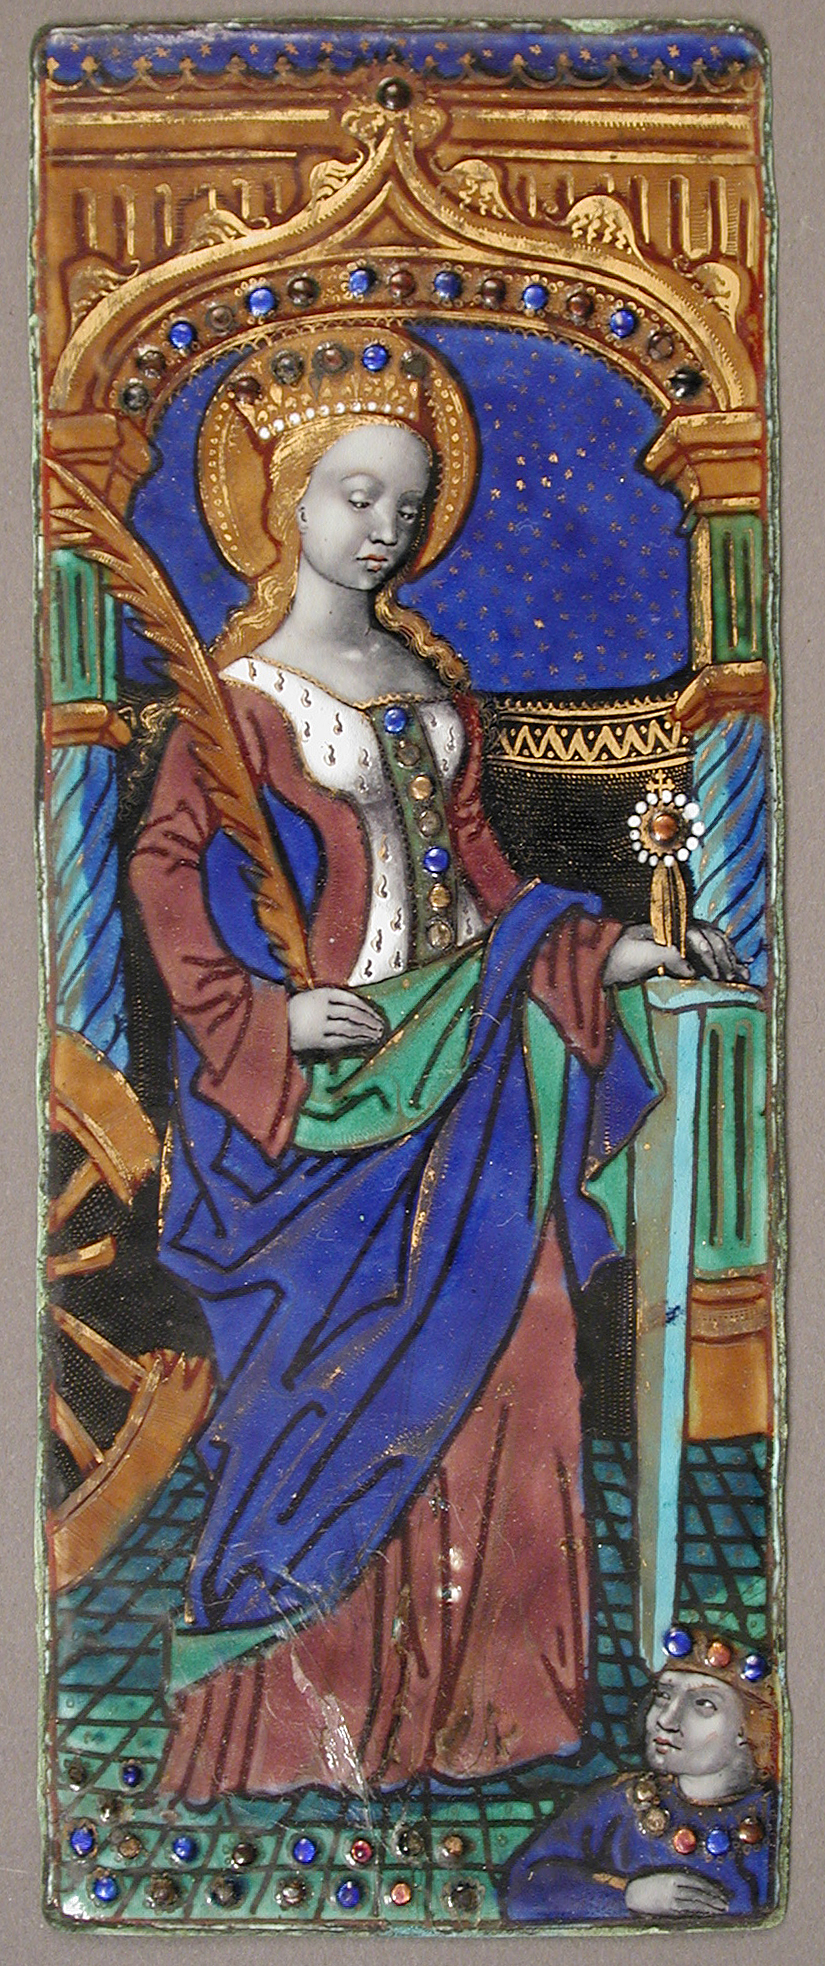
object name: triptych panel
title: Triptych Panel with Saint Catherine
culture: french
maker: master of the triptych of louis xii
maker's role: artist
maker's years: 1480-1525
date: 1401-1600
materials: copper, enamel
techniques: painting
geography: france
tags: swords,men